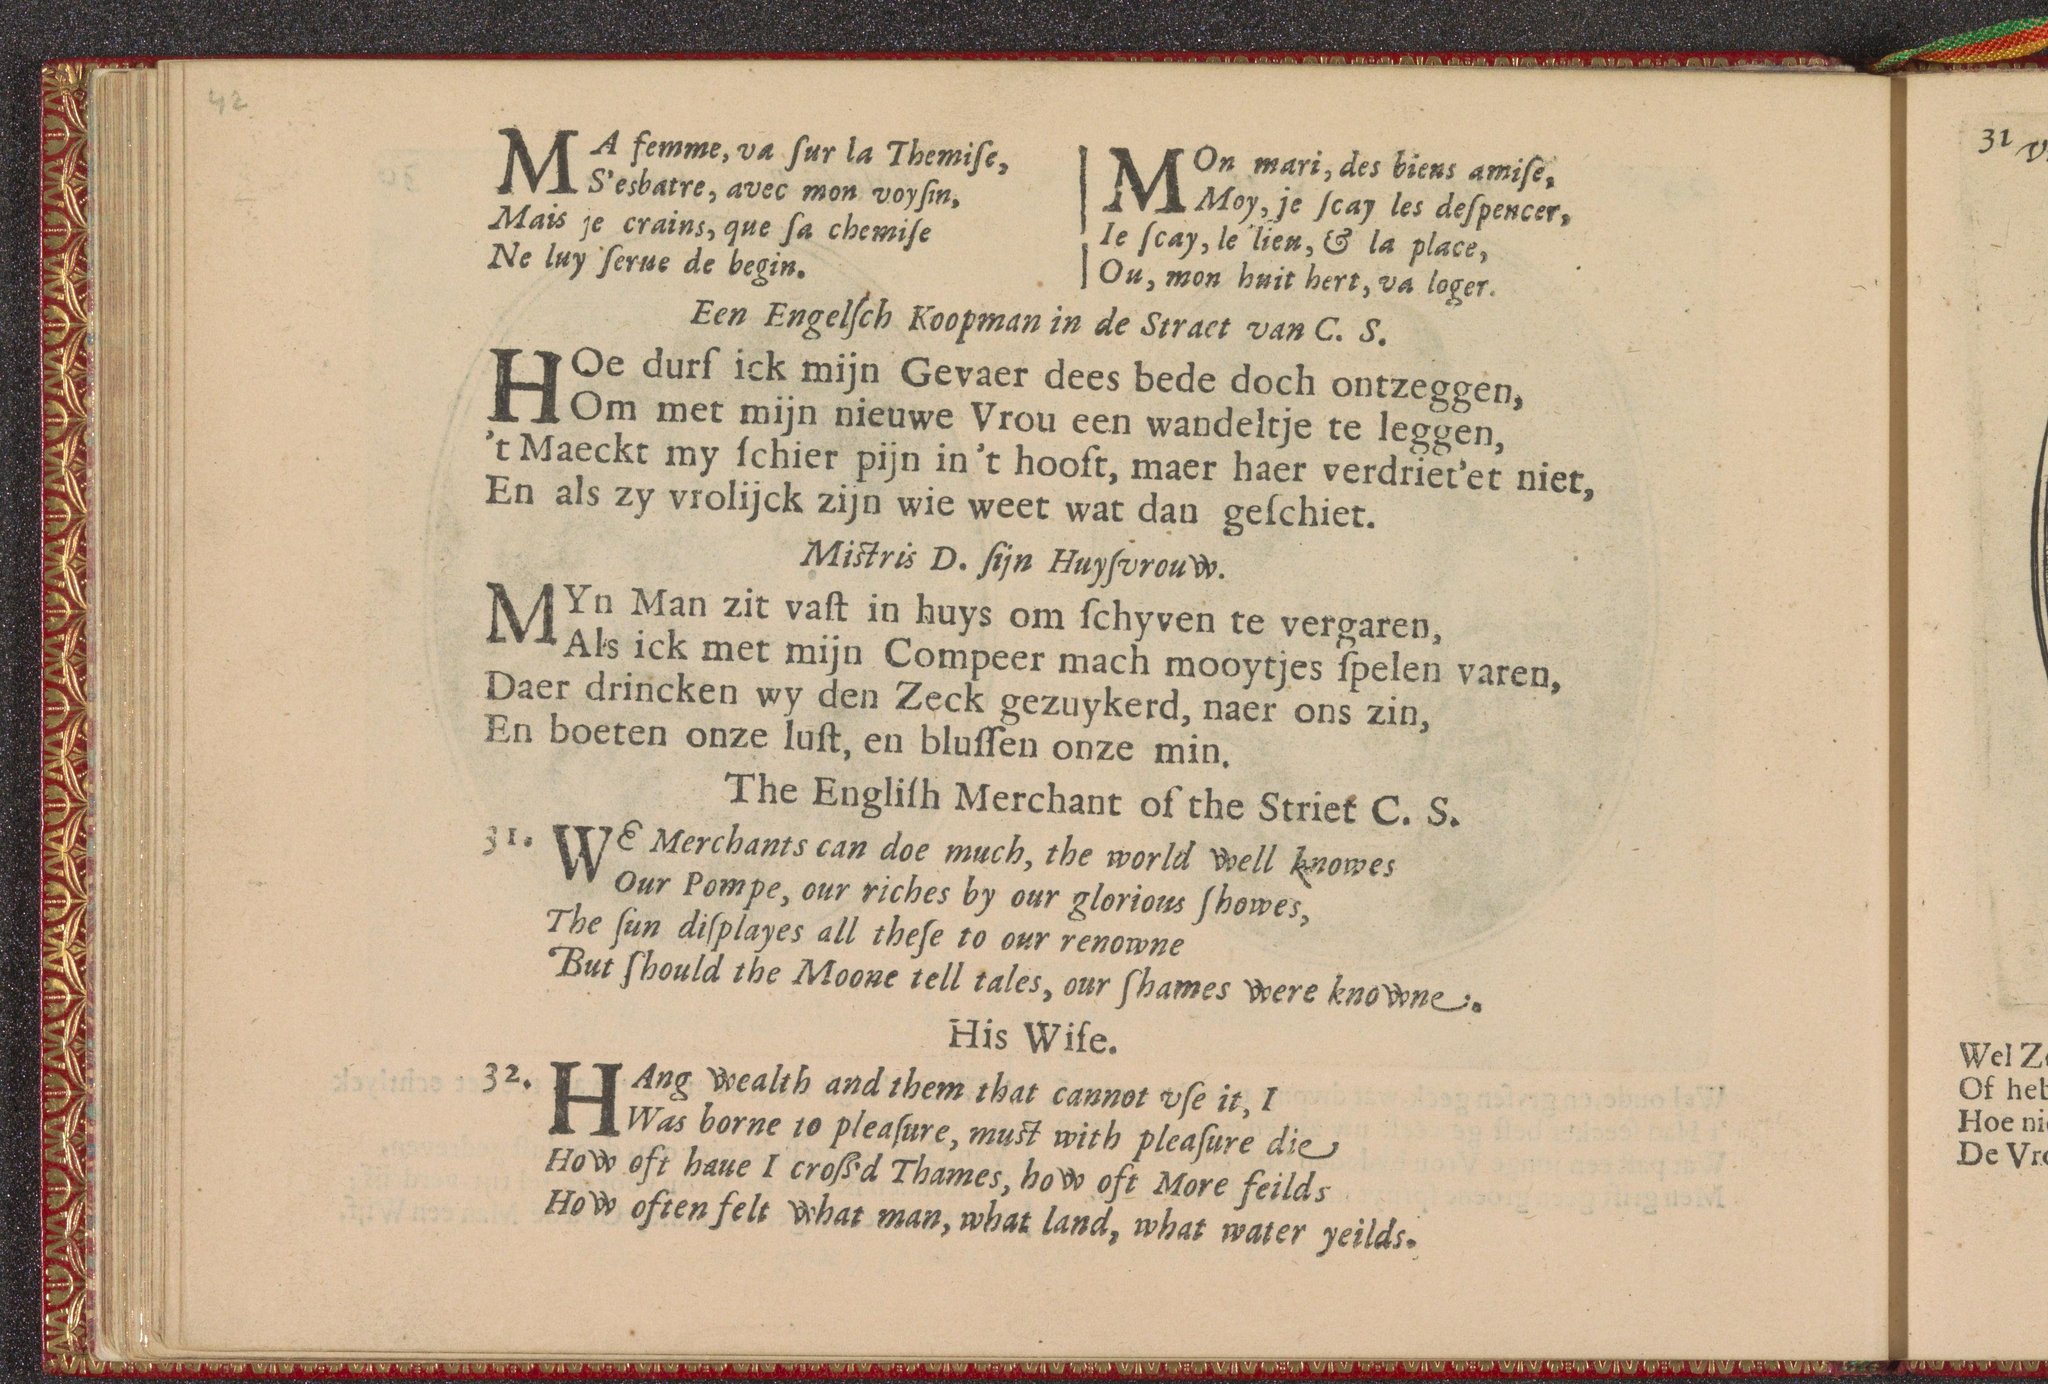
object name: text sheet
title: Les abus du mariage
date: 1641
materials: paper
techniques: letterpress printing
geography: amsterdam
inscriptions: date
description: Drie keer twee kwatrijnen in het Frans, Nederlands en Engels bij voorstellingen van een Engelse koopman en zijn vrouw. Het blad maakt deel uit van een album.